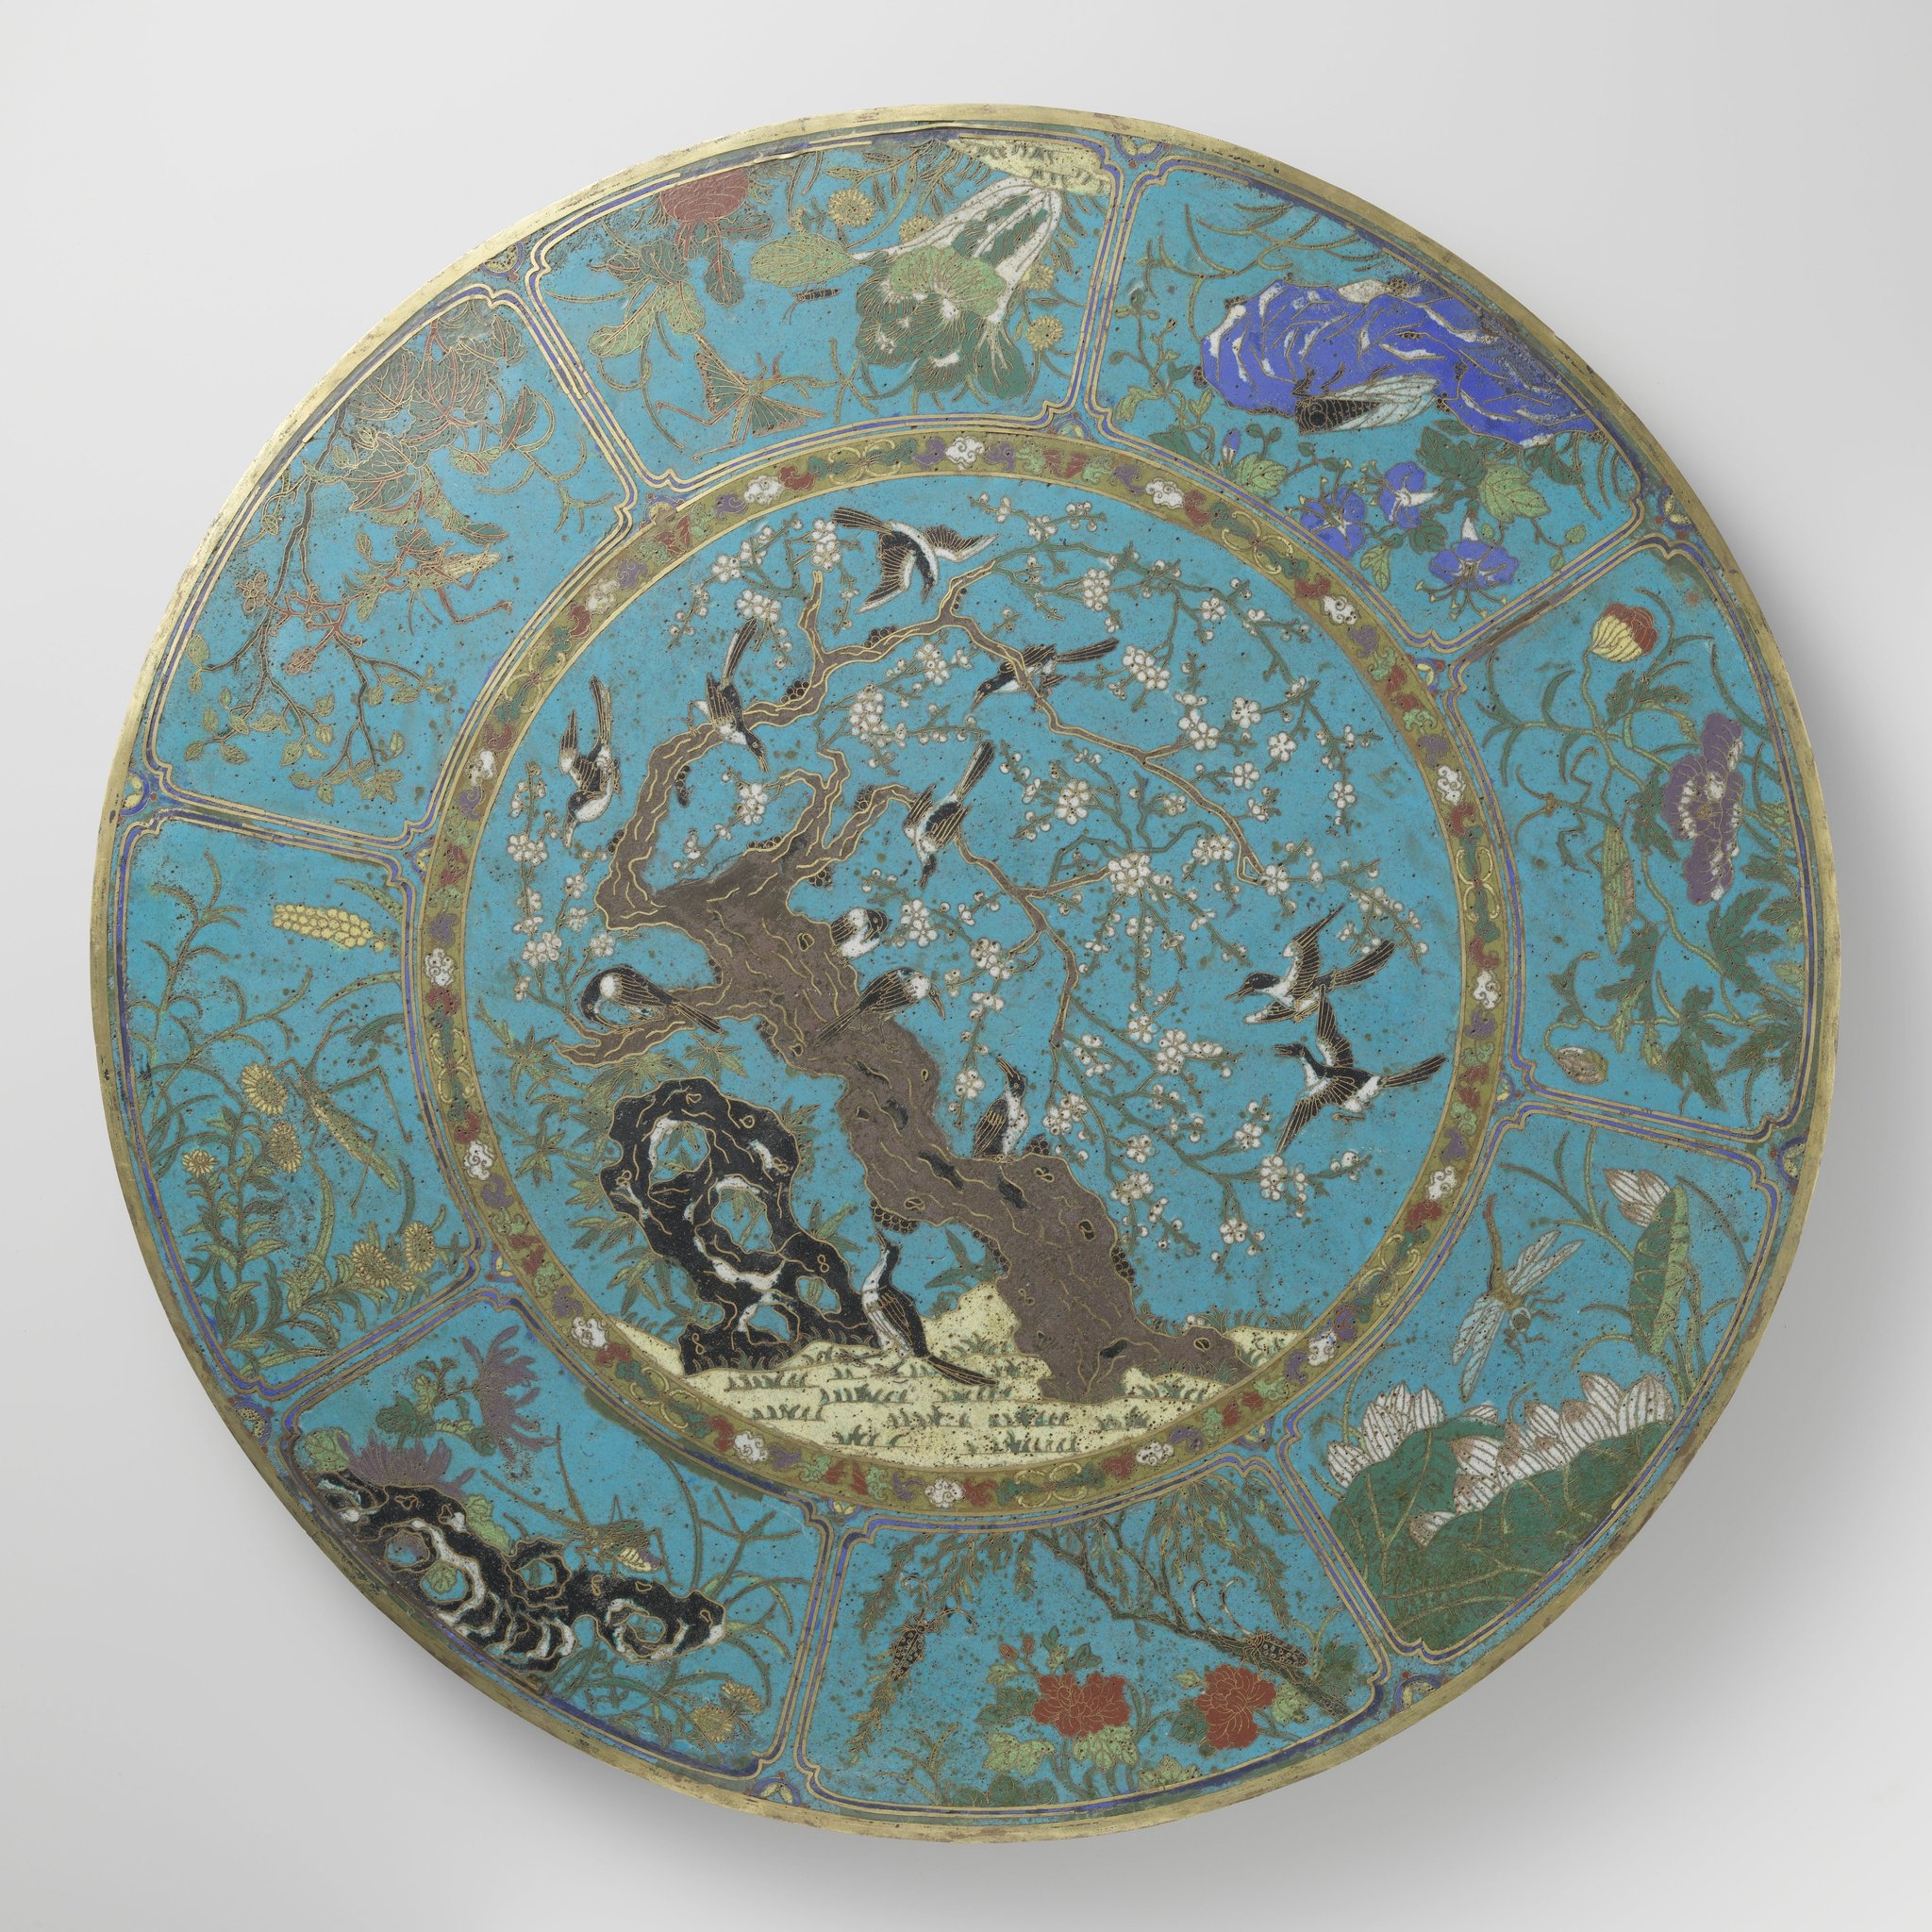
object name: plaque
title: Pair of plaques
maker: Anonymous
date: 1600-1699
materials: copper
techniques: enamel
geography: china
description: These plaques, possibly used as table tops, are covered with auspicious symbols: the butterfly represents a long life, and the magpie joy, while the blossoming plum tree and bamboo signify life force. The cloisonné enamel technique flourished in China from the Ming dynasty (1368–1644) onwards. Copper wire soldered onto the copper ground created the outlines of the design; these spaces were then filled with coloured glass paste, which melted and flowed when heated.